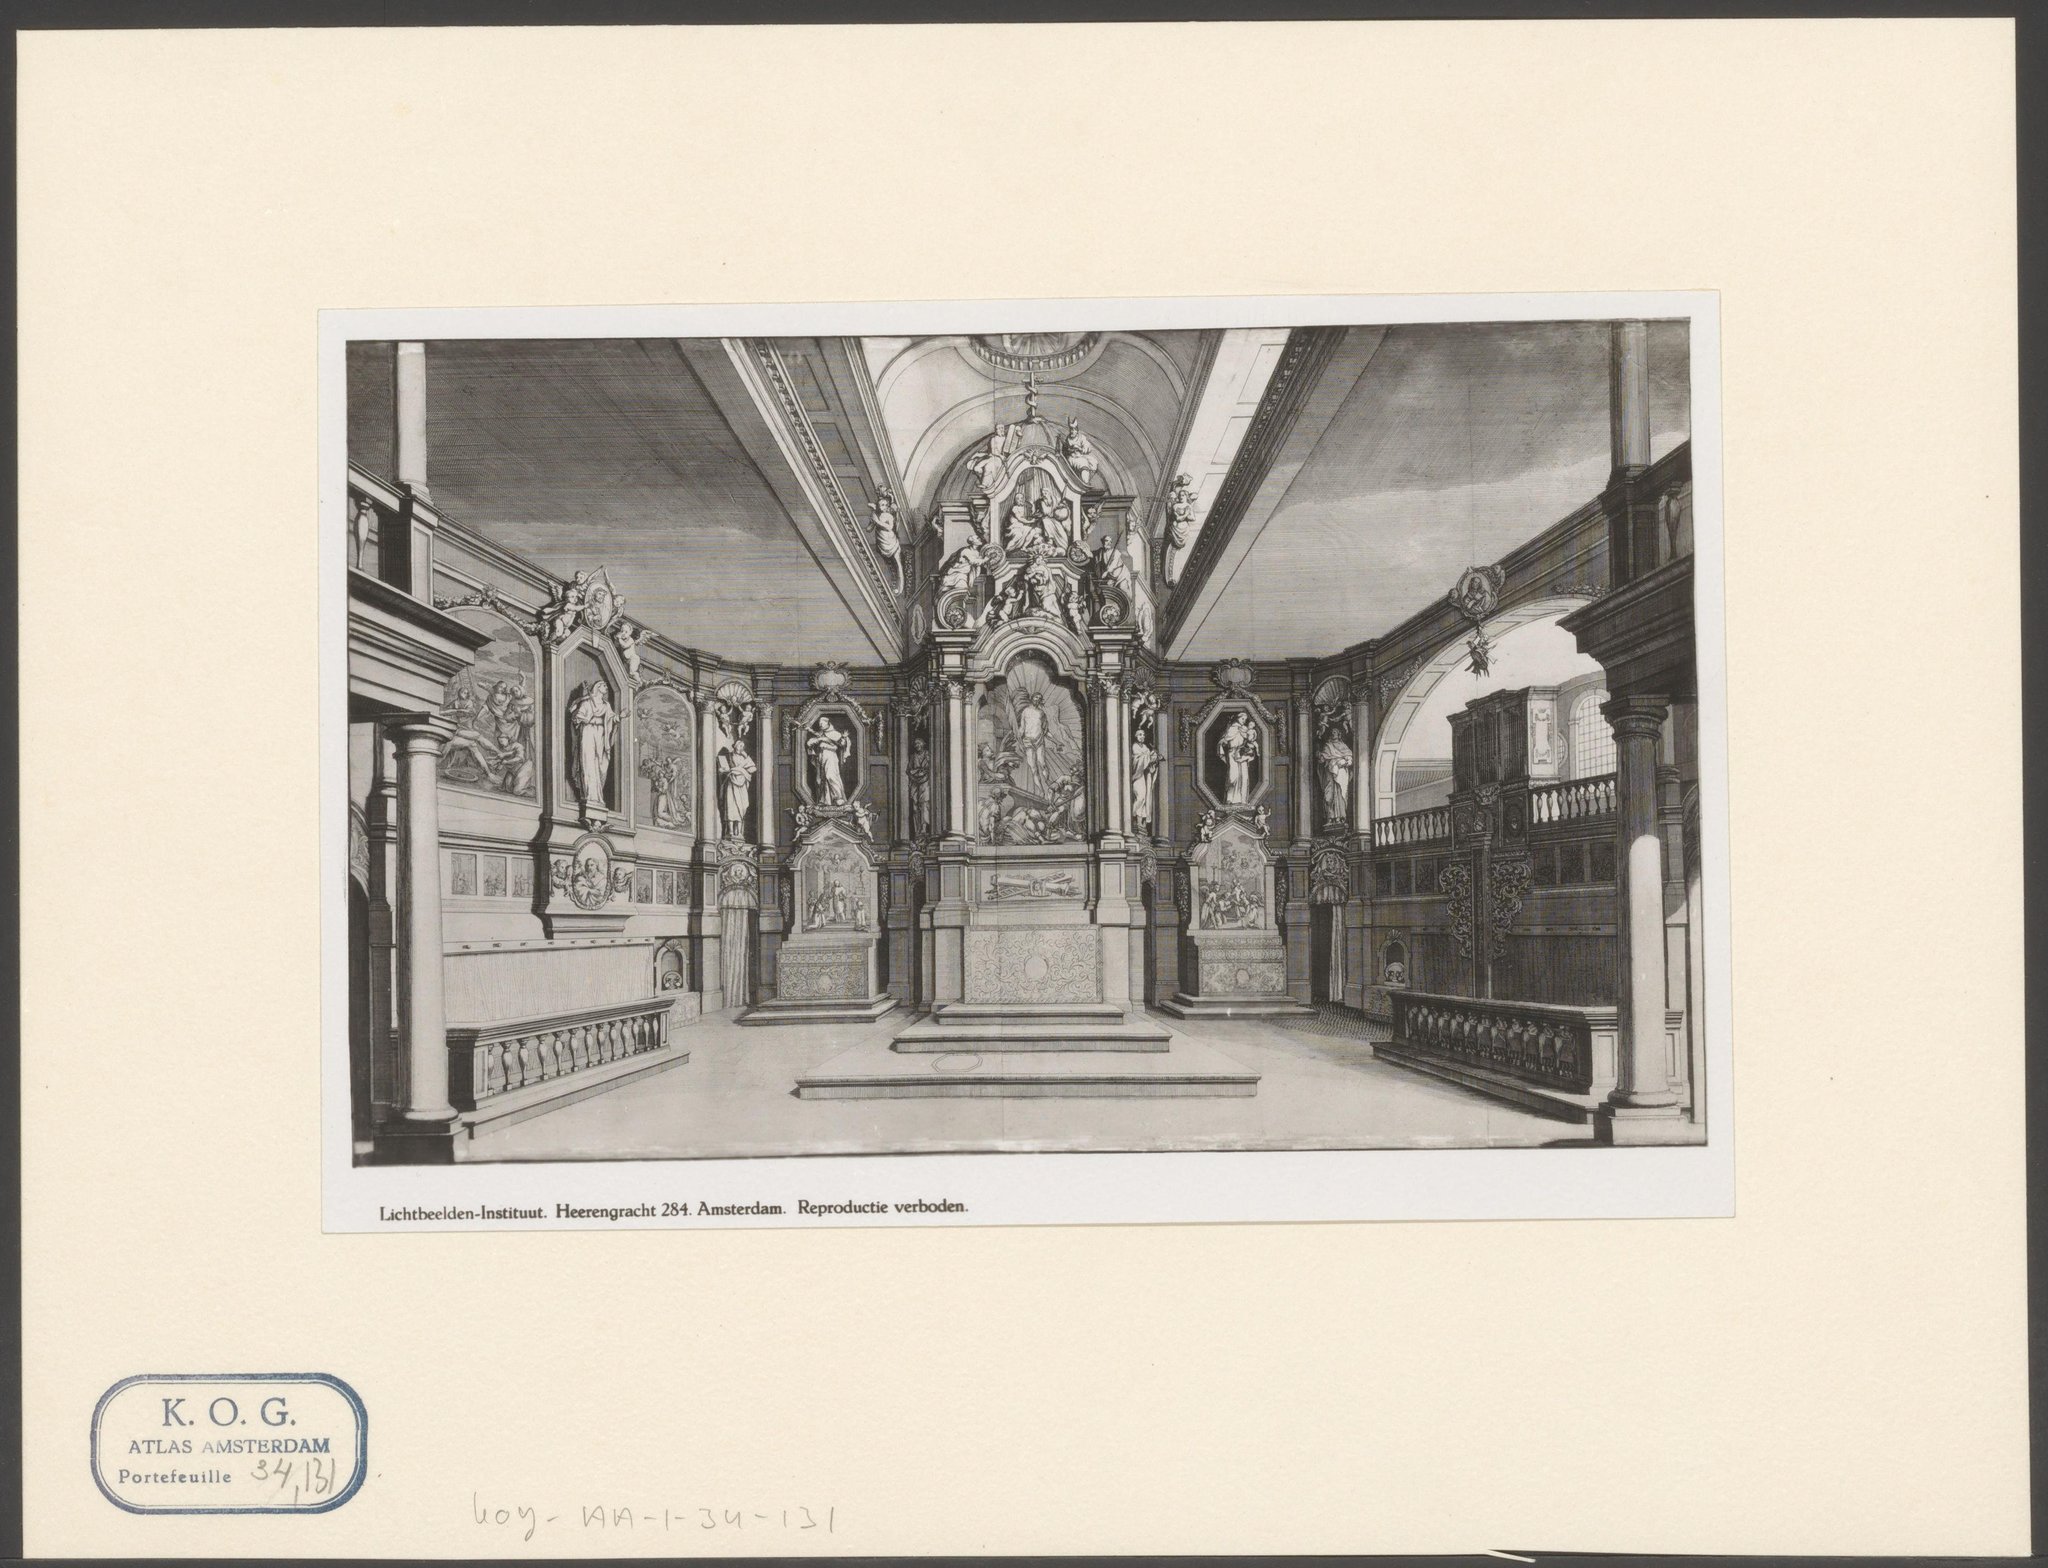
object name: photograph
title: Fotoreproductie van een prent van het interieur van de Mozes en Aäronkerk te Amsterdam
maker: Anonymous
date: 1935-1960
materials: paper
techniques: gelatin silver print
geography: netherlands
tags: interior of church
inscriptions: inscription: ‘Lichtbeelden-Instituut. Heerengracht 284. Amsterdam. Reproductie verboden.’, collector's mark: Lugt 1641b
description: Onderwerpsrubriek binnen de Atlas Amsterdam: Kerkwezen: R.K. Gemeenten: Begijnhof t/m Petrus en Paulus.